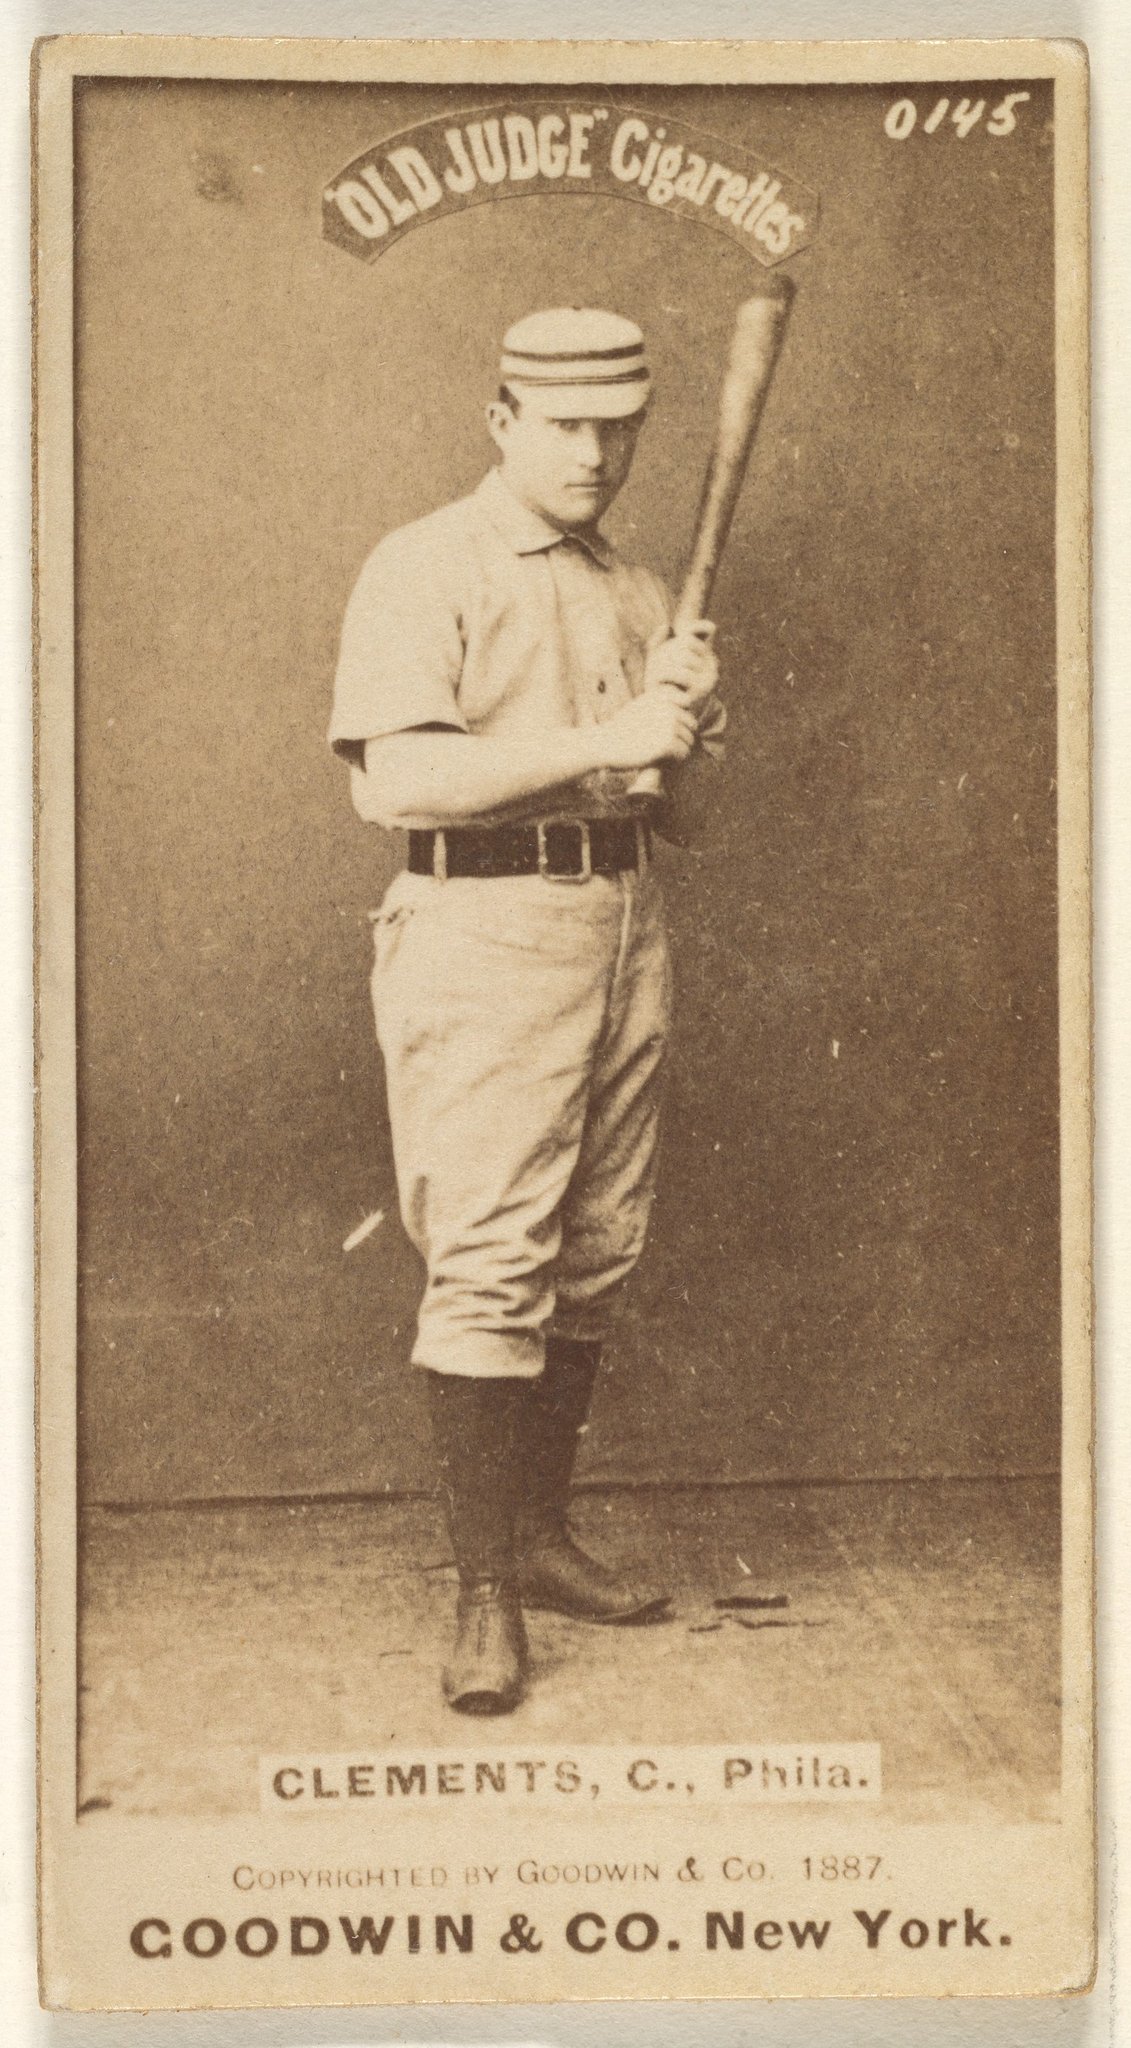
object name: baseball card, photograph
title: John J. "Jack" Clements, Catcher, Philadelphia, from the Old Judge series (N172) for Old Judge Cigarettes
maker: goodwin & company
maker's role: publisher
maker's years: 1850-1950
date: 1887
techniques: albumen silver print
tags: men,portraits,baseball,athletes